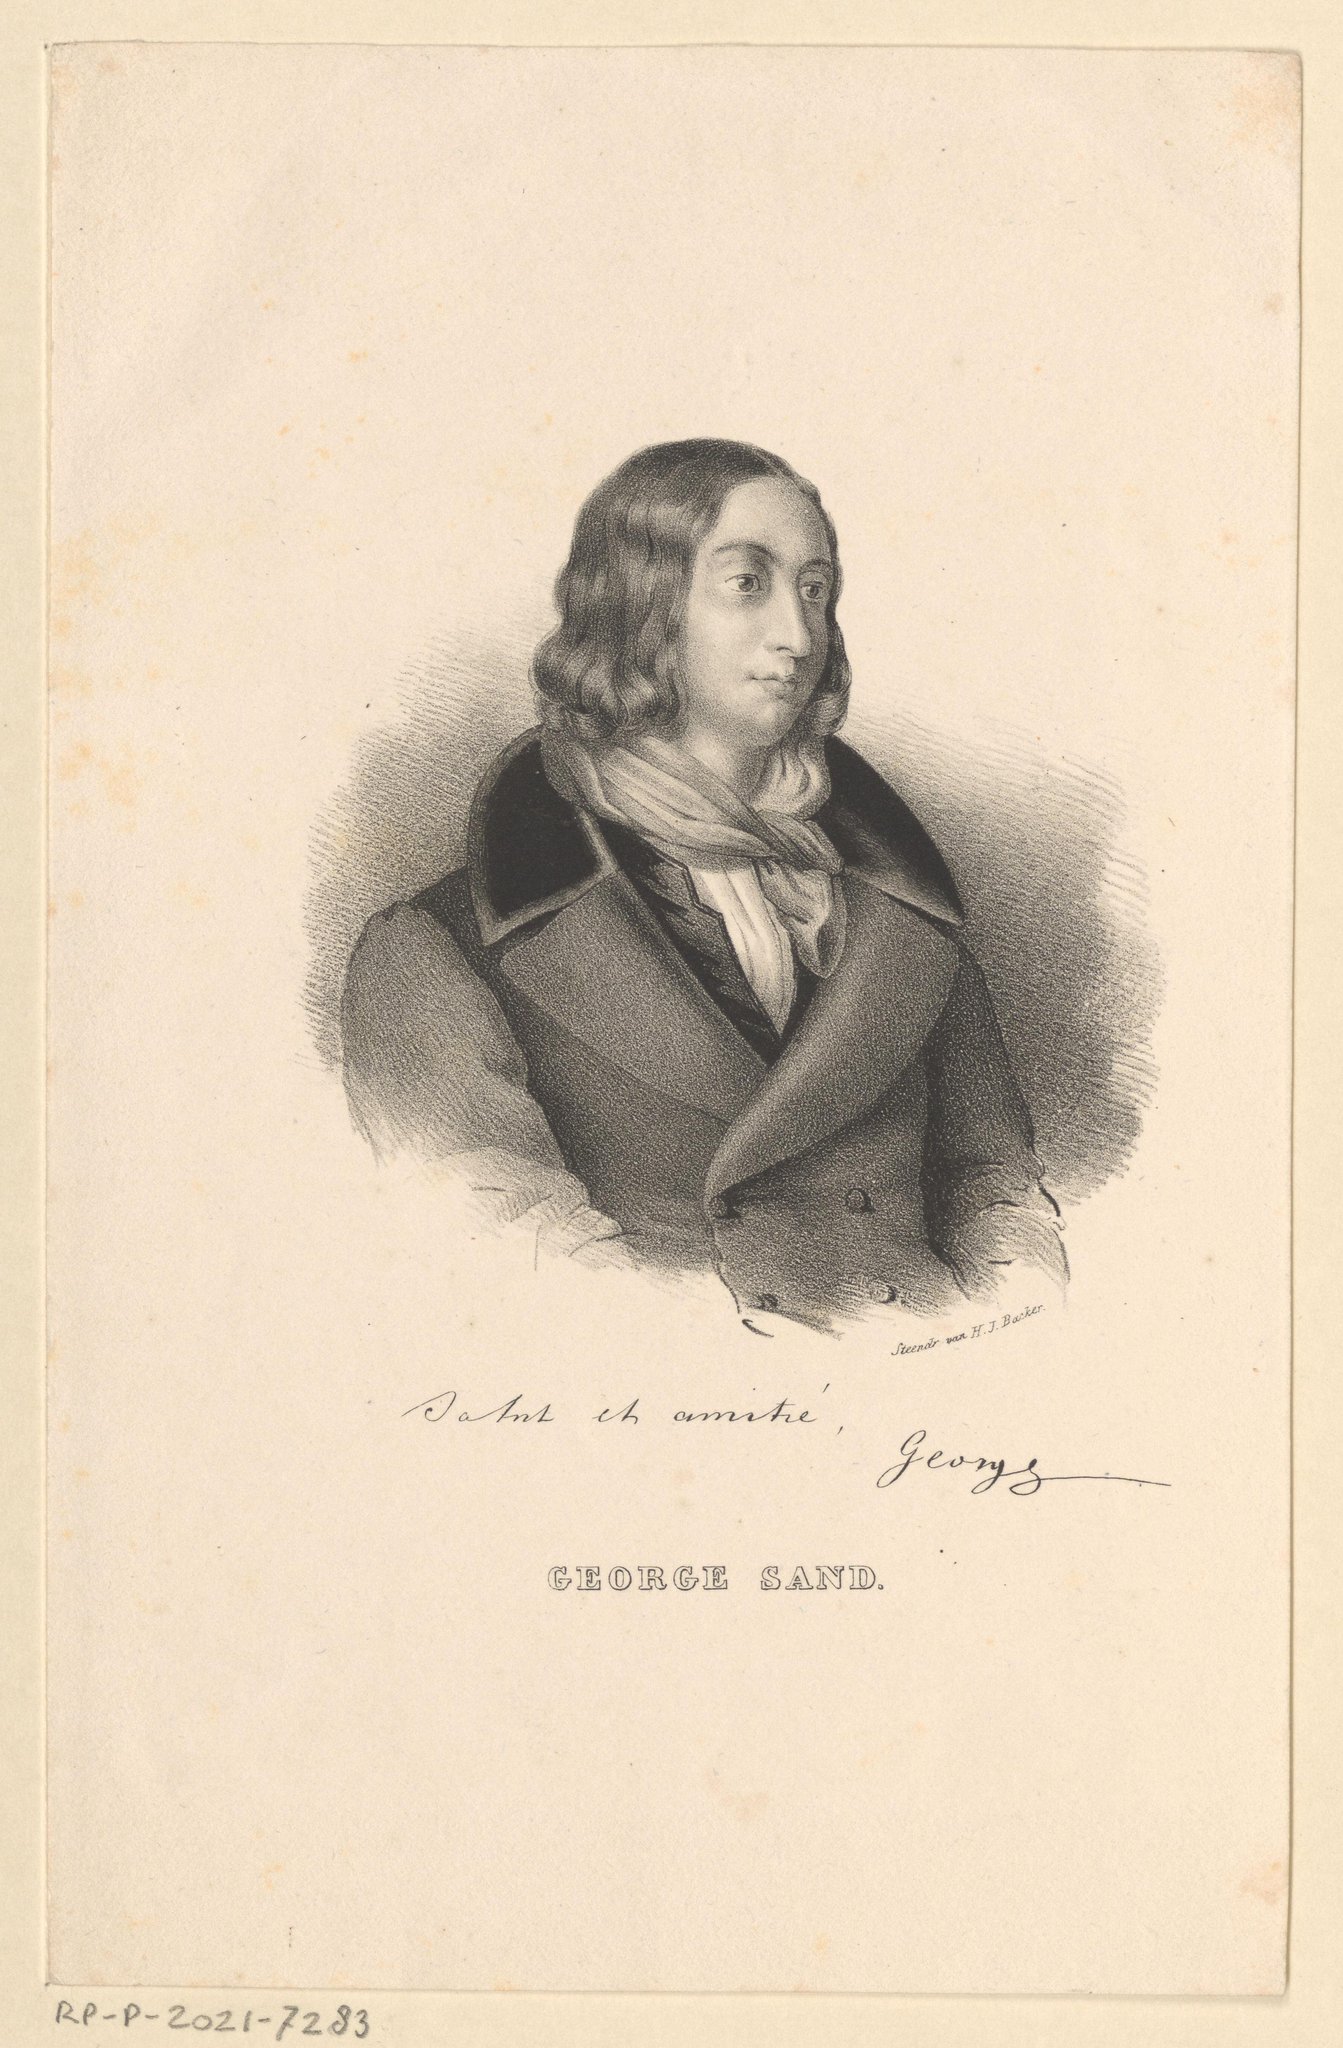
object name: print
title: Portret van George Sand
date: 1833-1845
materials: paper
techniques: lithograph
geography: the hague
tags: paris, george sand, historical persons - bb - woman, portrait of a writer